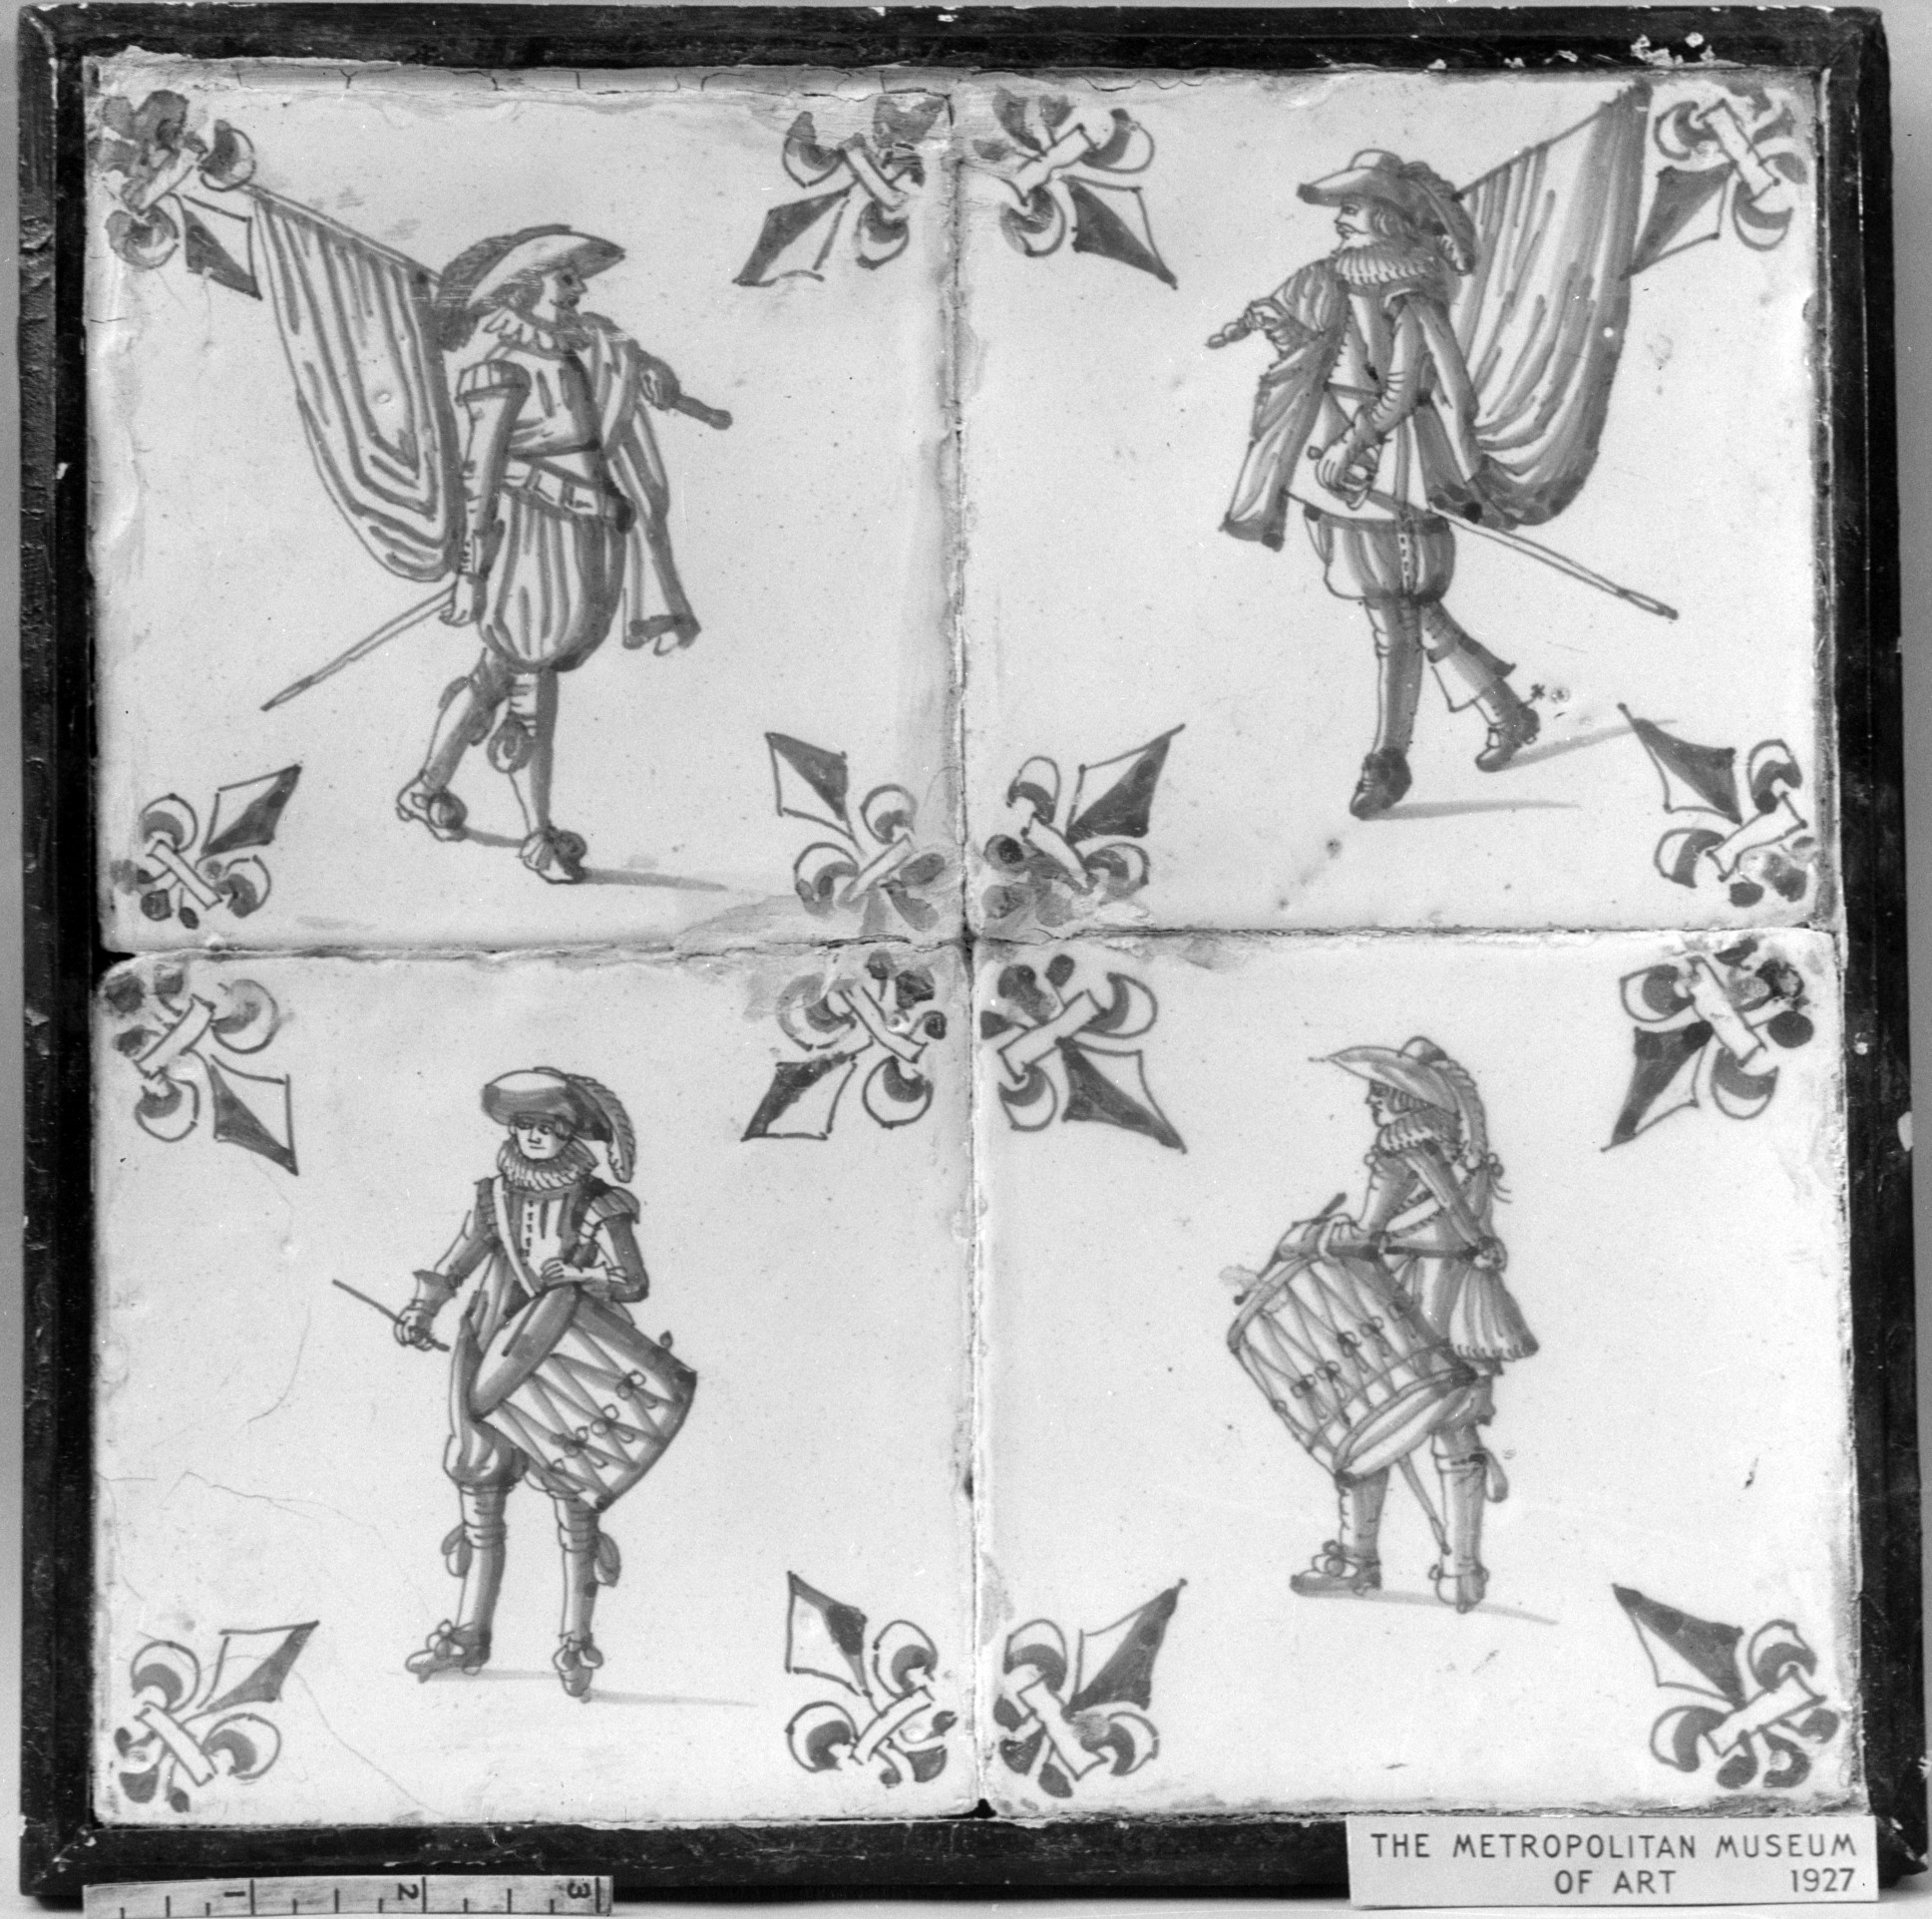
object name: tile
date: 1701-1900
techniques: glazing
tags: men,drums,flags